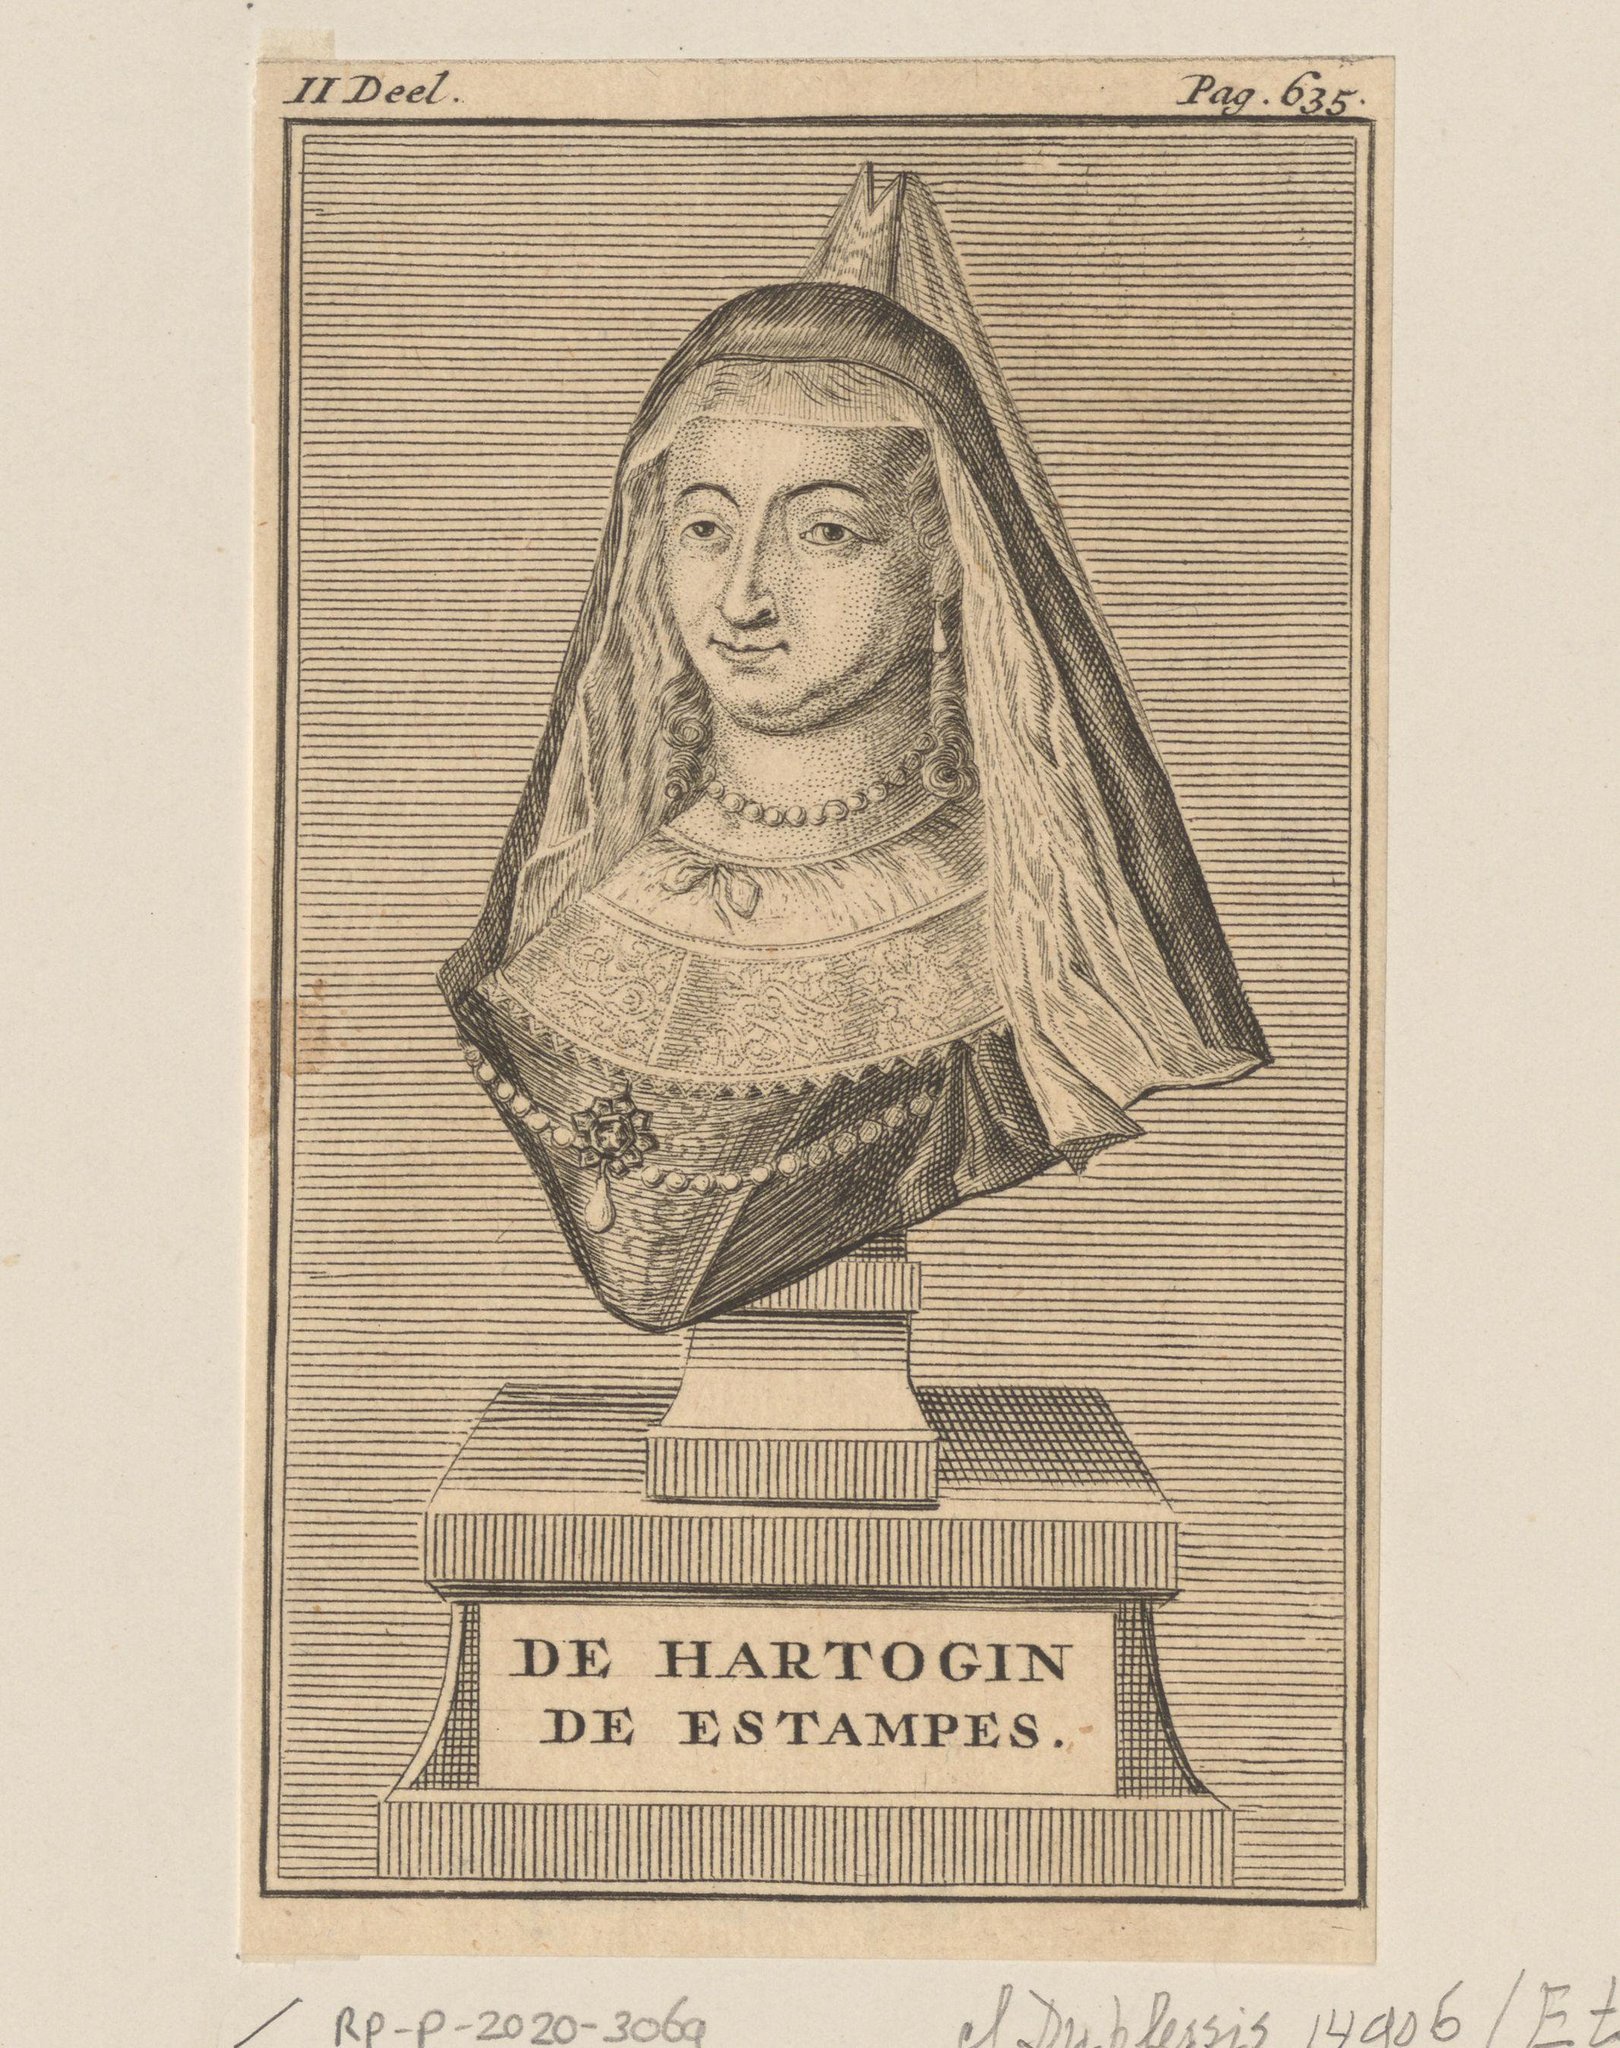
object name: print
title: Portretbuste van Anne de Pisseleu d'Heilly, hertogin van Étampes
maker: Anonymous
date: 1650-1750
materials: paper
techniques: etching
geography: northern netherlands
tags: historical persons - bb - woman, pearl; pearl necklace, veil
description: Linksboven: II Deel. Rechtsboven: Pag. 635.